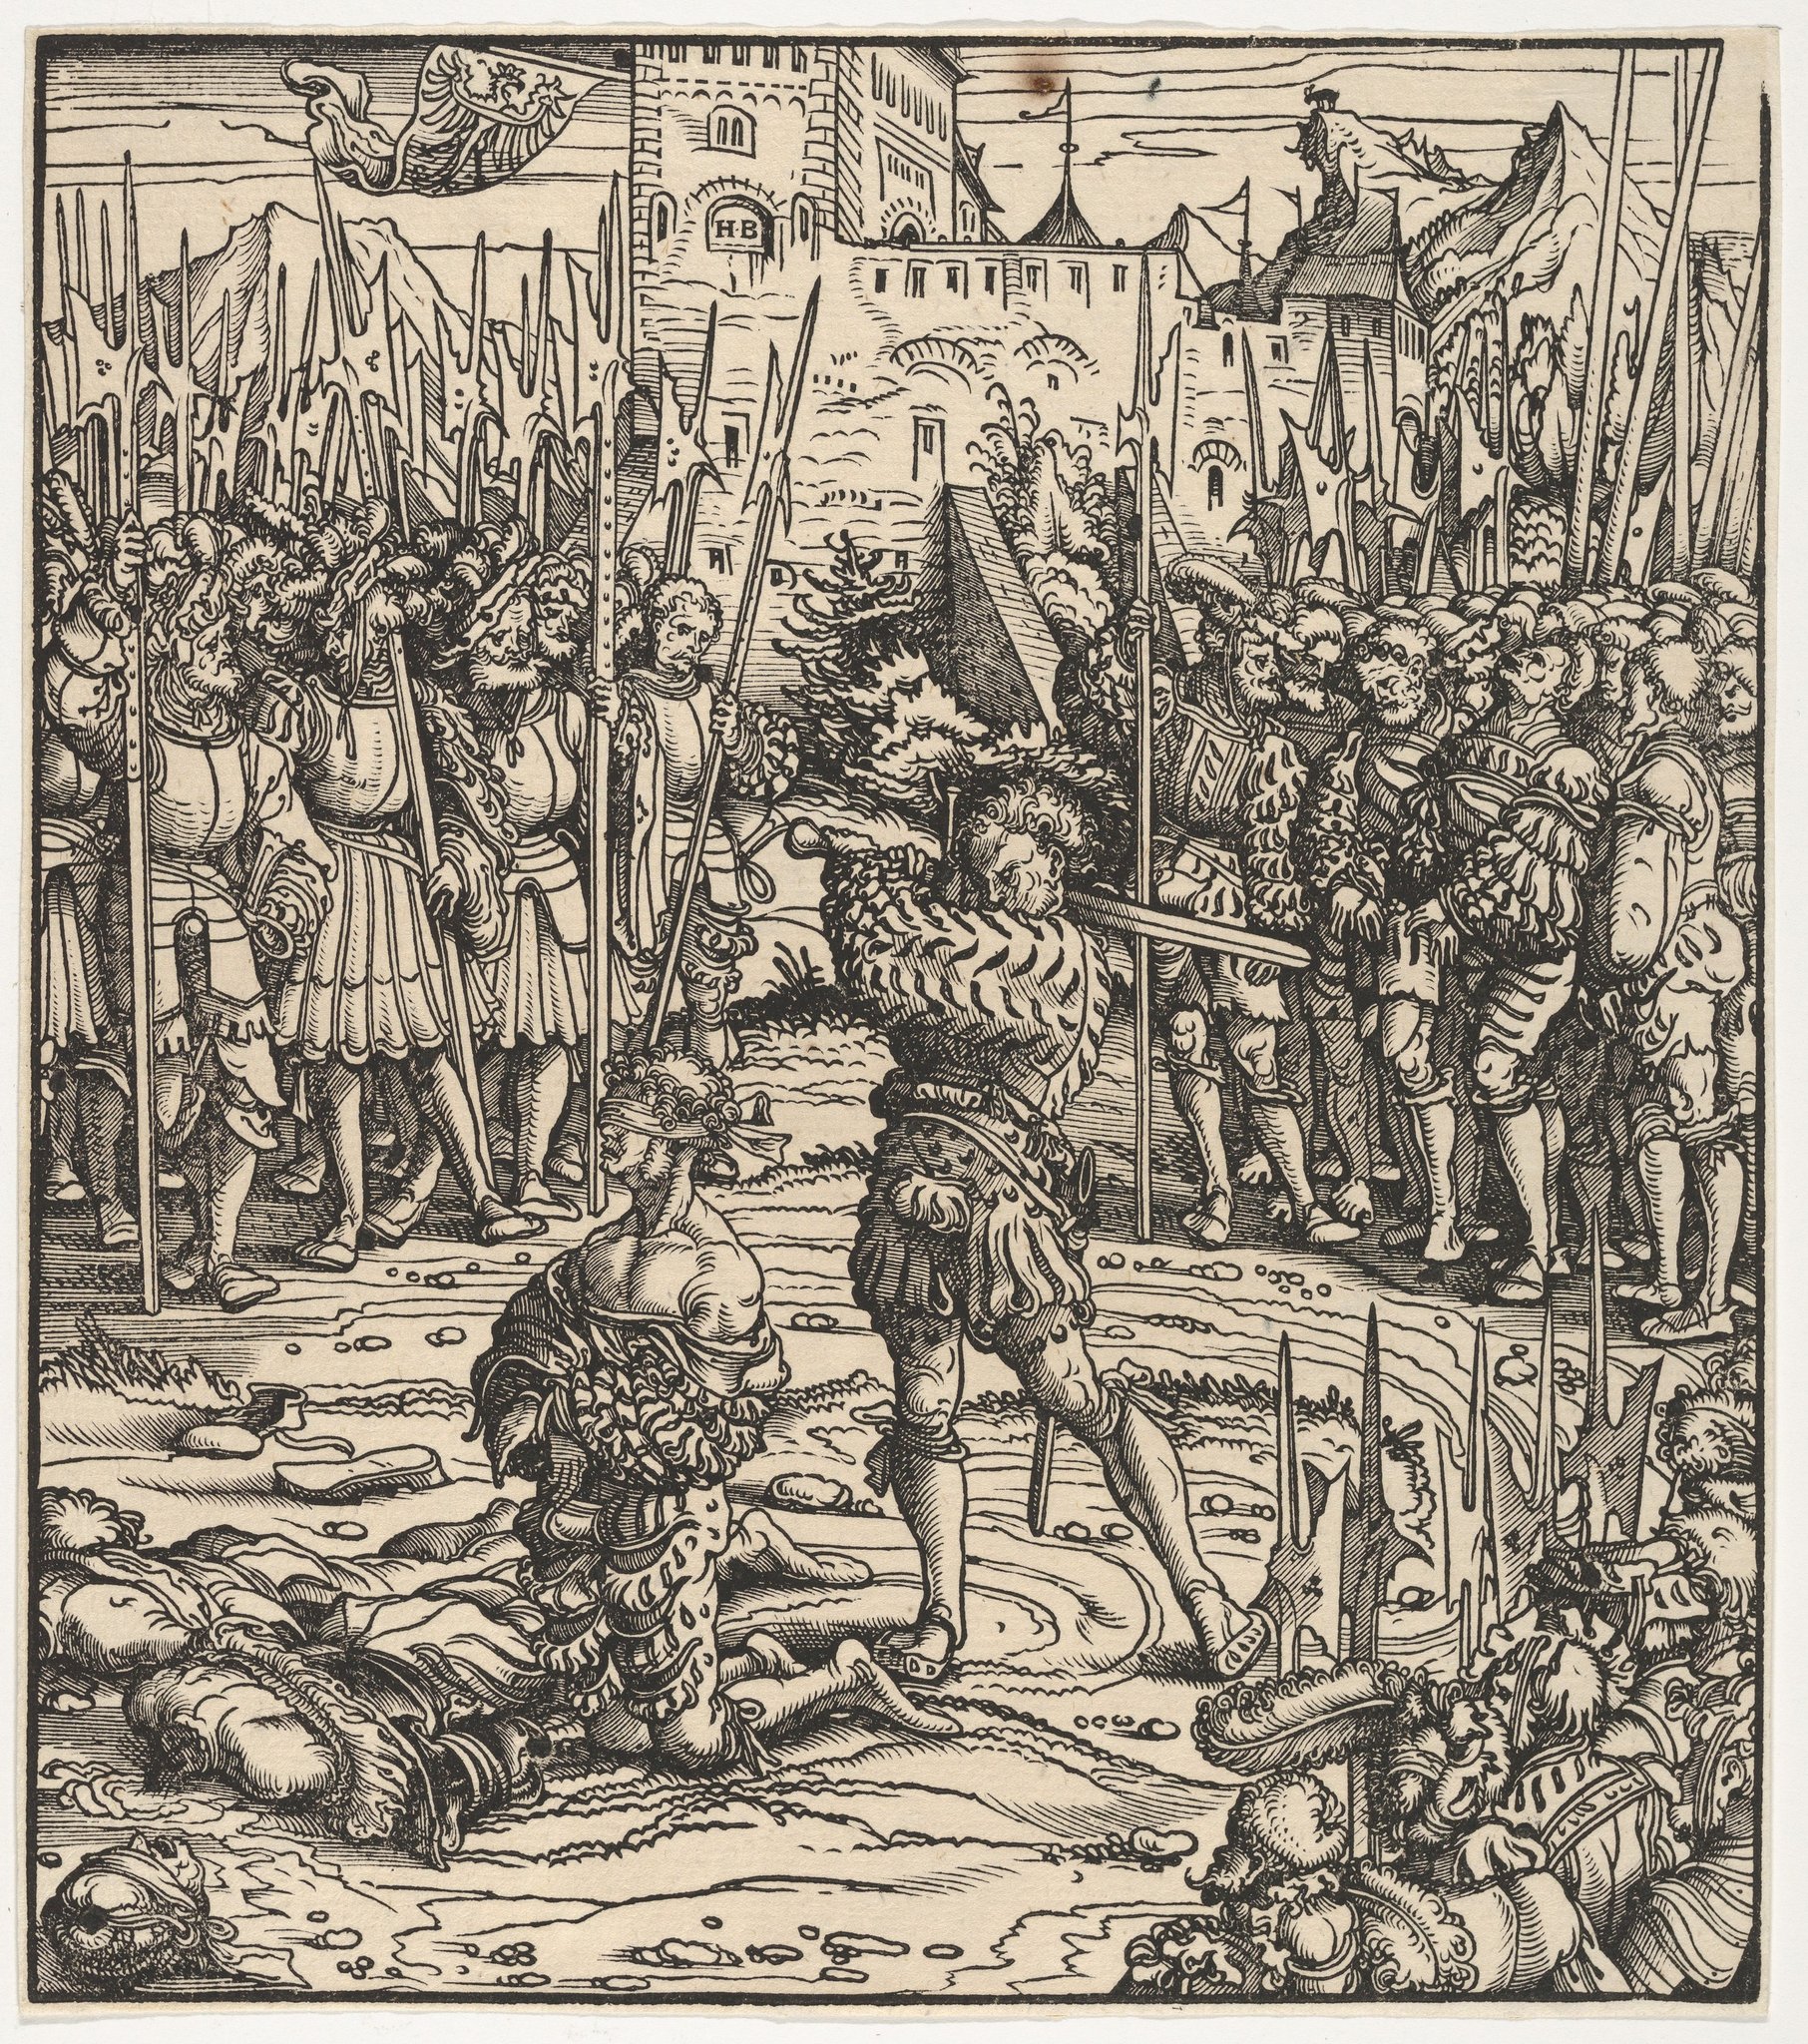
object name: print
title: The Execution of the Guardian of Kufstein, from "Der Weisskunig"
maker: hans burgkmair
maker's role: artist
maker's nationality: german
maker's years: 1473-1531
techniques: woodcut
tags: soldiers,weapons,men,execution